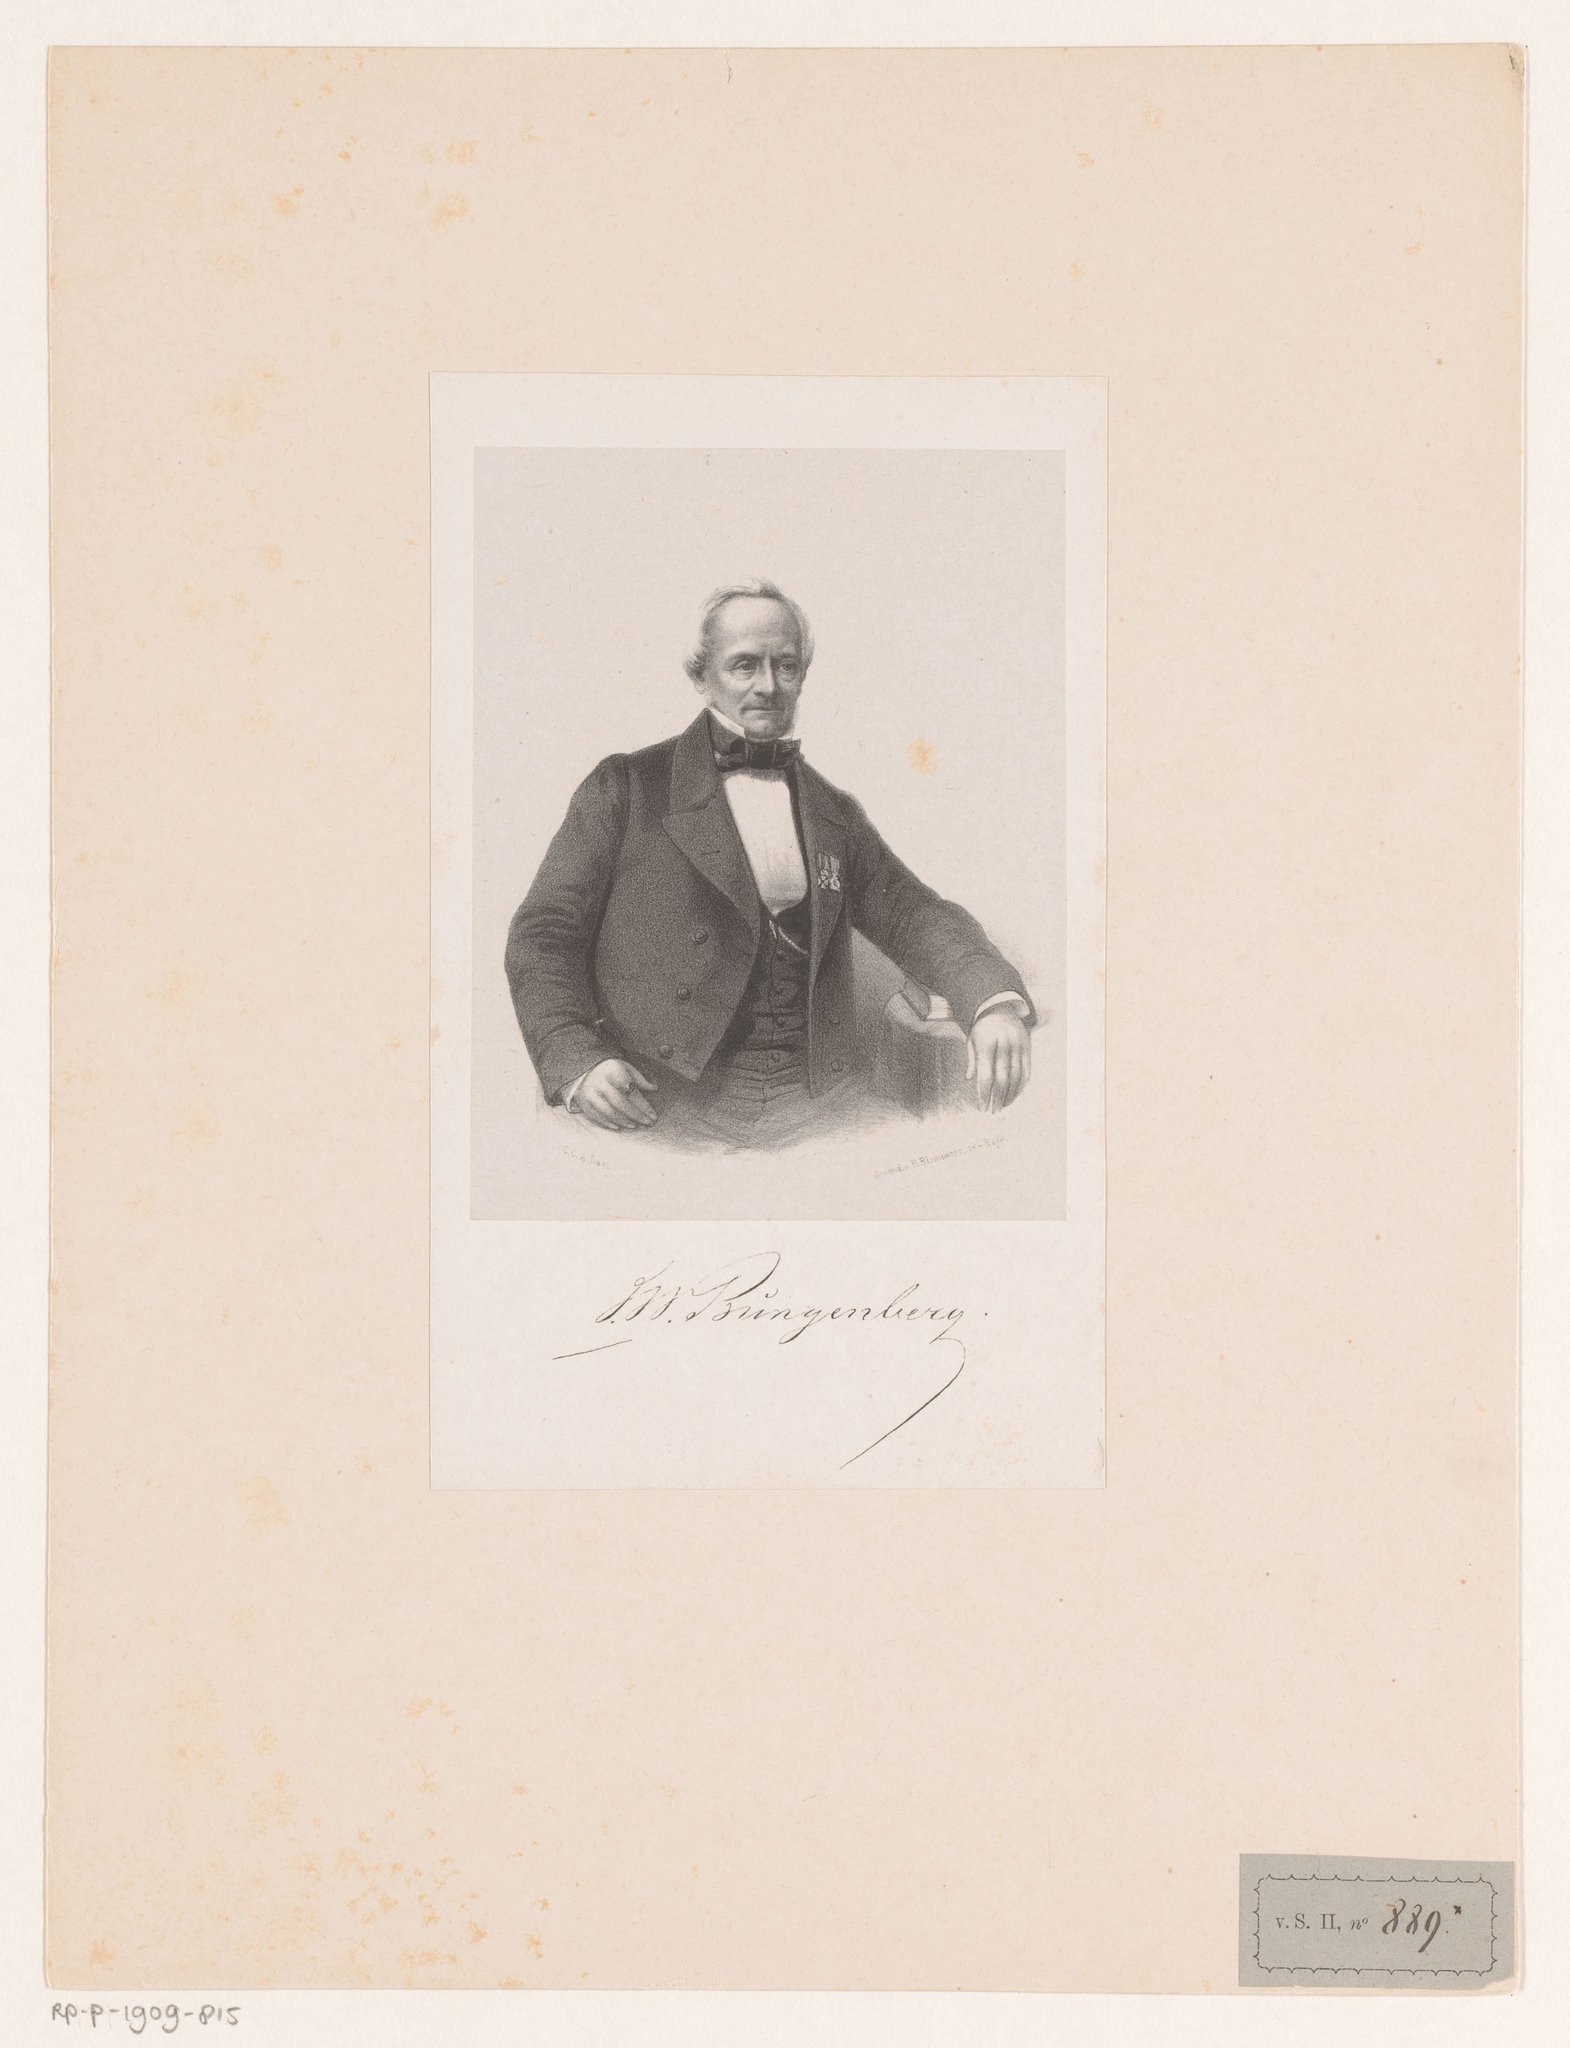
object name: print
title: Portret van J.W. Bungenberg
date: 1842-1887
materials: paper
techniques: lithograph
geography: the hague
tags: knighthood order, historical persons (+ half-length portrait)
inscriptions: collector's mark: Lugt 2228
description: De geportretteerde draagt twee ridderorden. Onder het portret zijn signatuur.